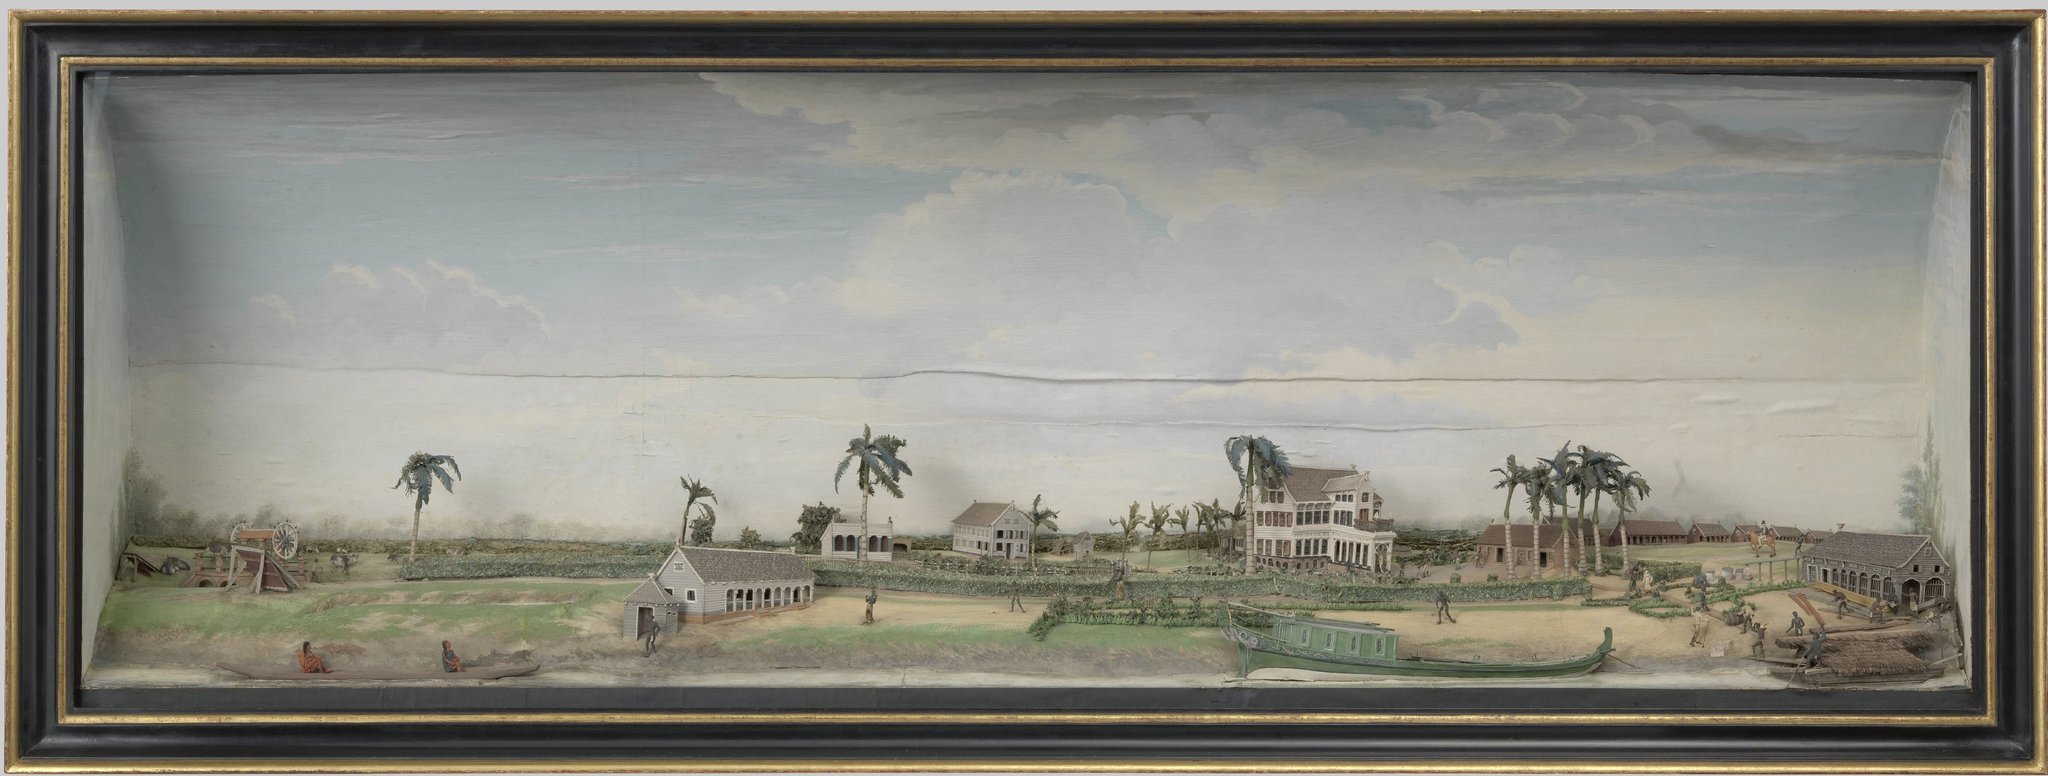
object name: diorama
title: Diorama of the Zeezigt Coffee and Cotton Plantation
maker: gerrit schouten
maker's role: draughtsman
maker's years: 1779-1839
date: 1815-1821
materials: glue, paint, paper, plastic, wood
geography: suriname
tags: plantation, housing, rowing-boat, canoe, etc., slavery; serfs and enslaved persons, trees: palm-tree, suriname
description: In the mid-19th century, almost 800 men, women and children held in slavery worked on the Zeezigt coffee and cotton plantation. Yet only a few of them are to be seen in the diorama. They sweep the coffee-drying floor, spread the cotton in the sun and work in the carpentry workshop. Schouten also depicted an overseer on horseback taking a fugitive man back to the plantation.